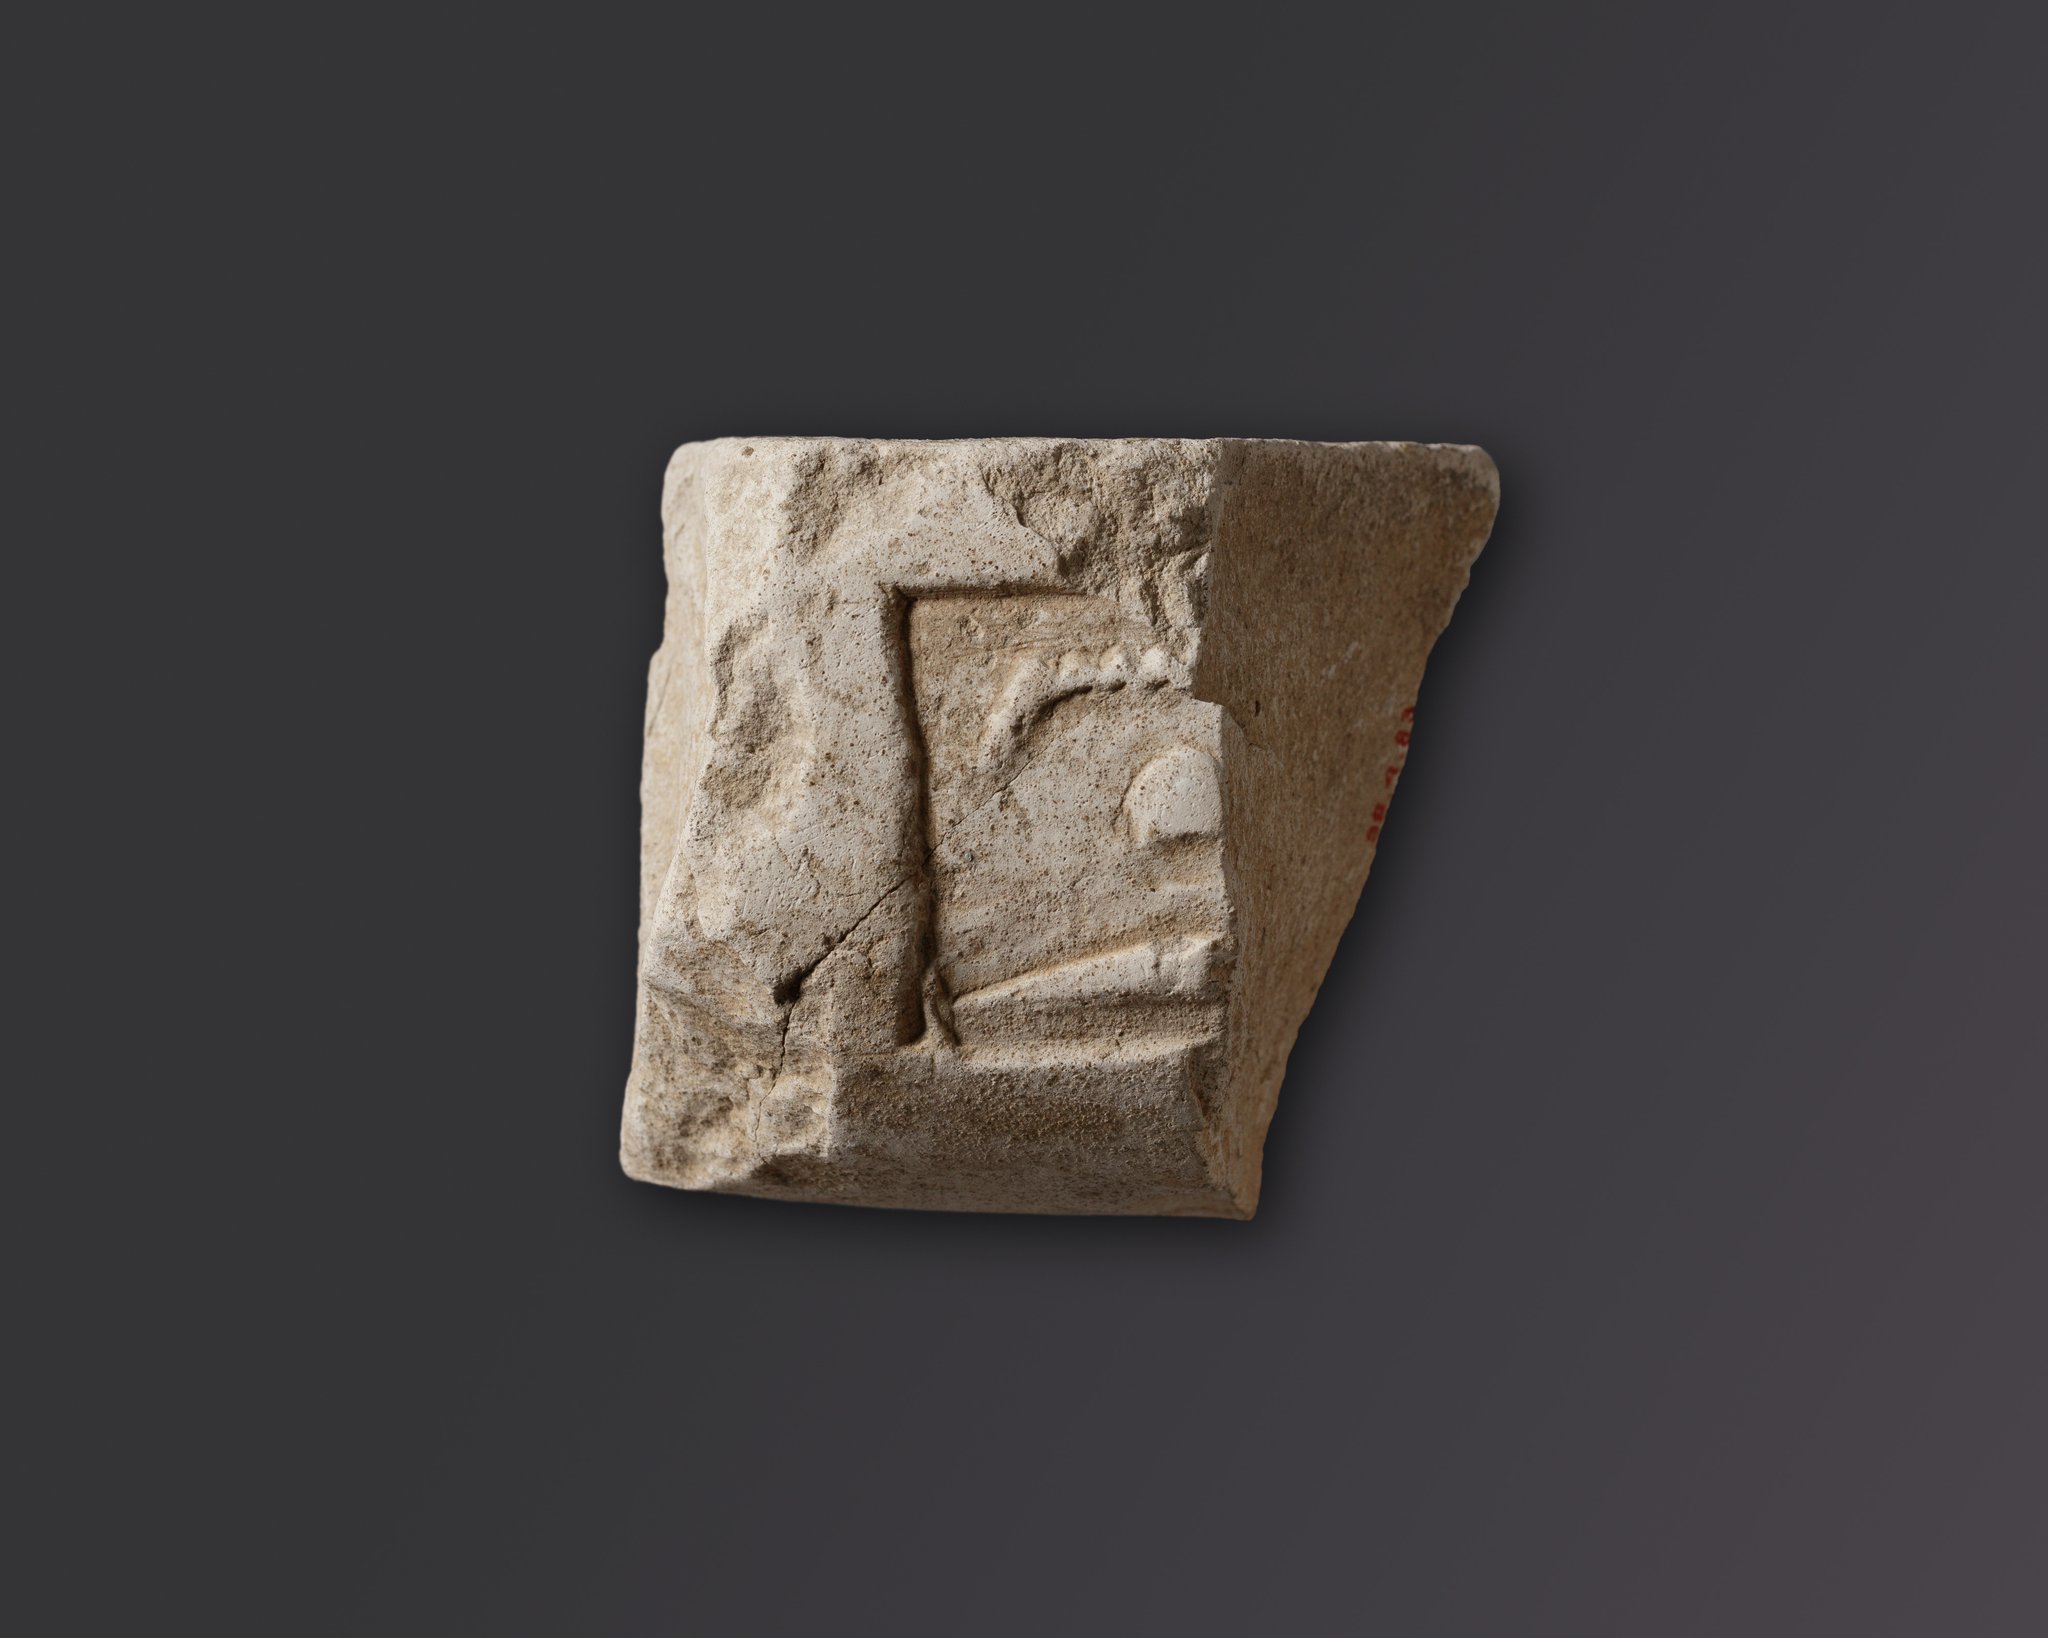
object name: door drum section, intef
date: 2100-2090 BCE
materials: limestone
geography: egypt